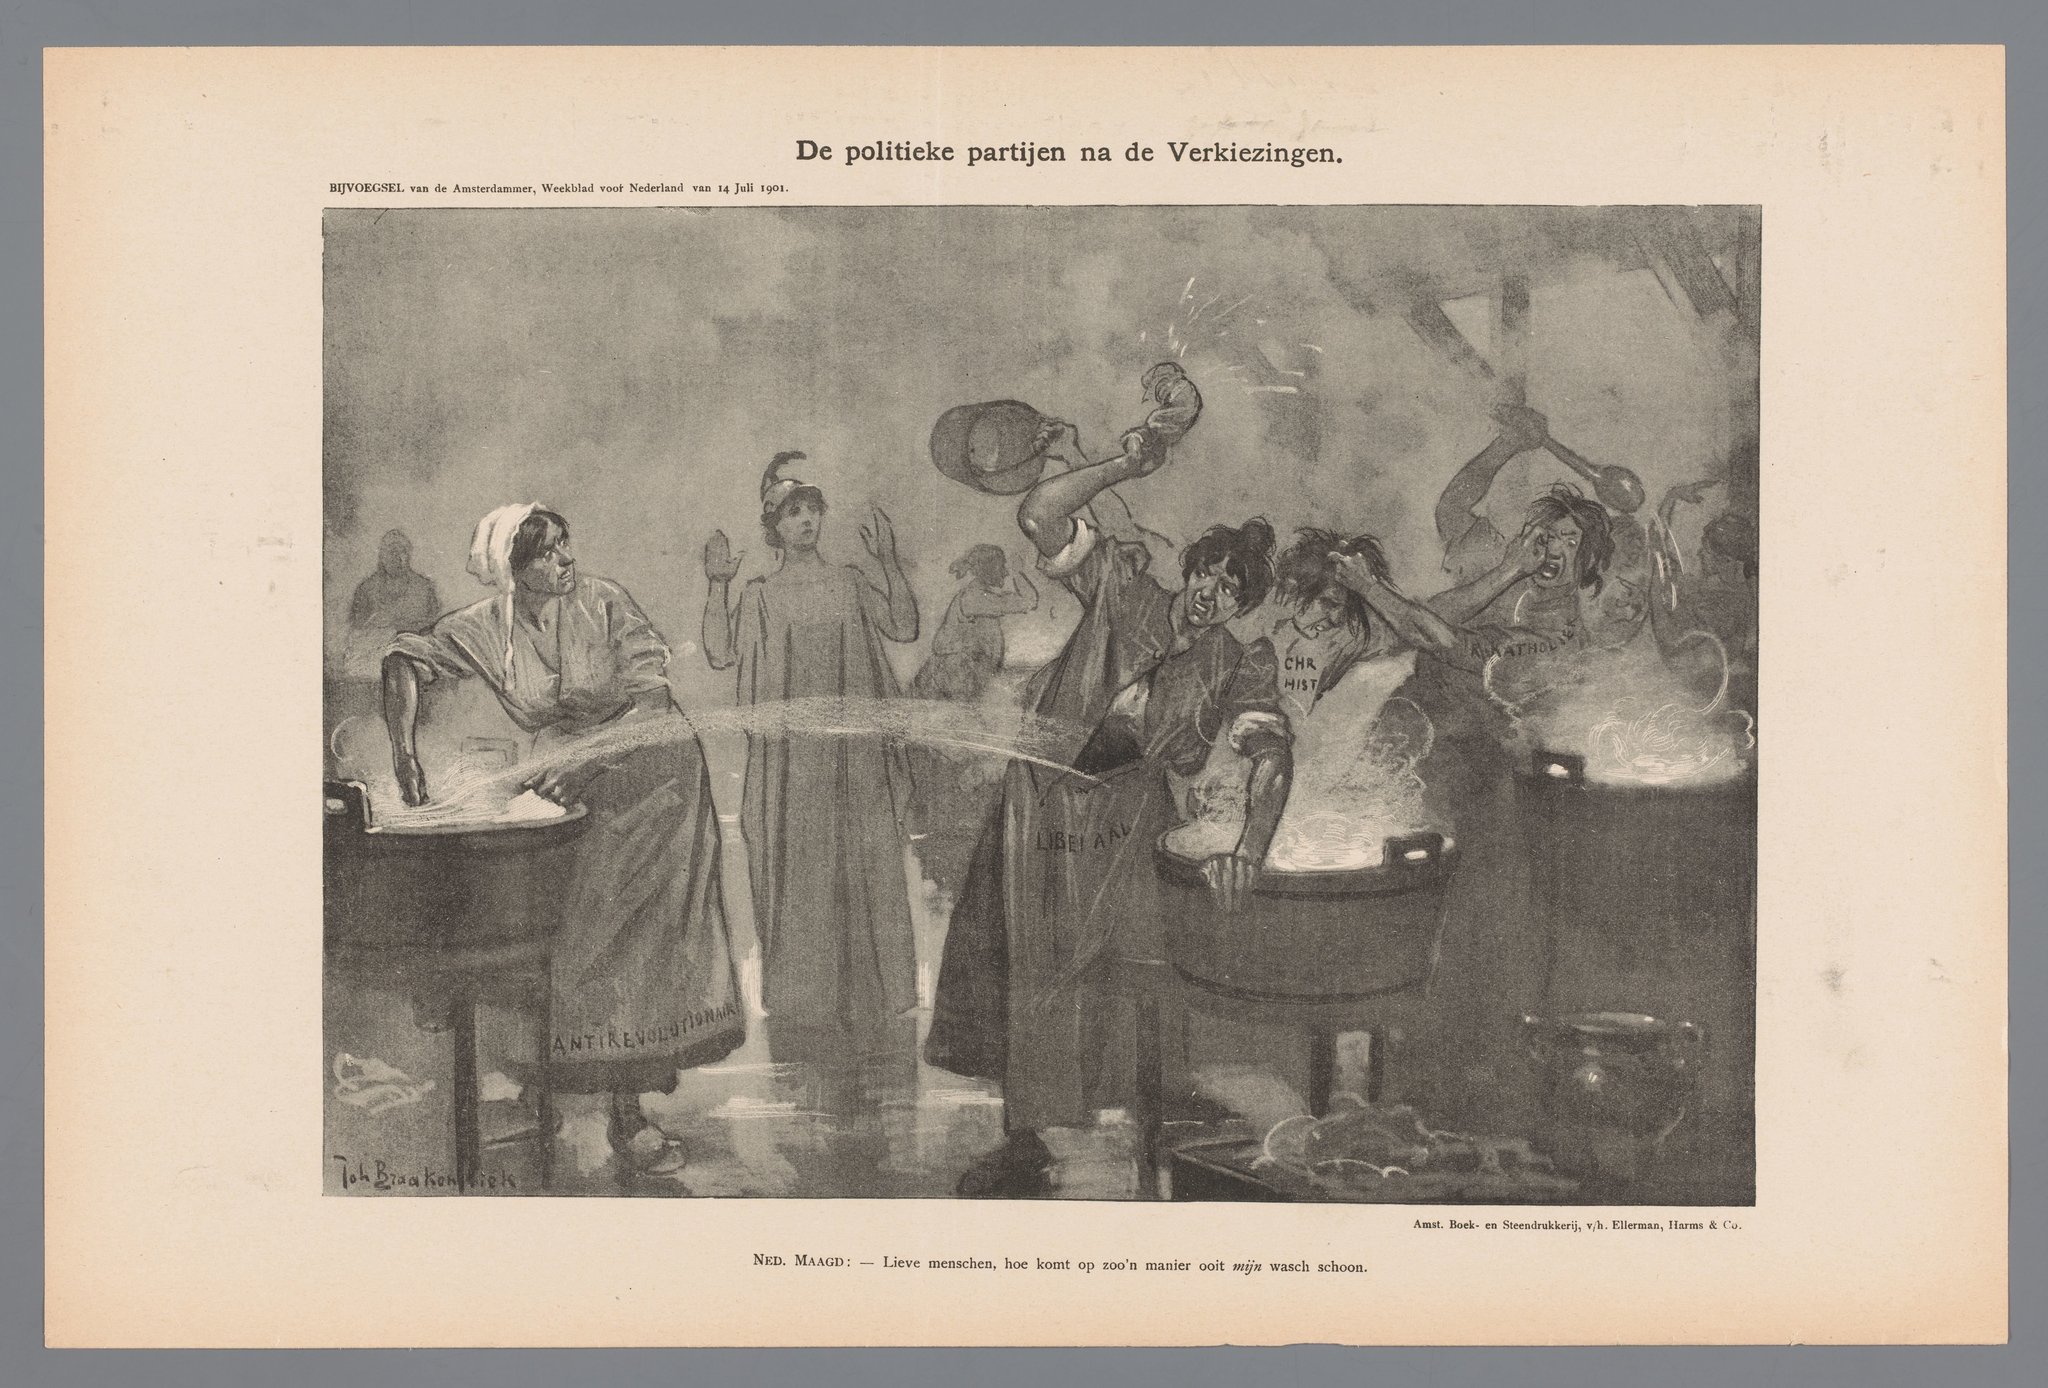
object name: cartoon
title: De politieke partijen na de Verkiezingen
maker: johan braakensiek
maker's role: draughtsman, print maker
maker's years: 1858-1940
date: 1901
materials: paper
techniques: lithograph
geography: amsterdam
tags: laundering, political caricatures and satires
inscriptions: date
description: Prent uit het bijvoegsel van: De Amsterdammer. Weekblad voor Nederland, 14 juli 1901.